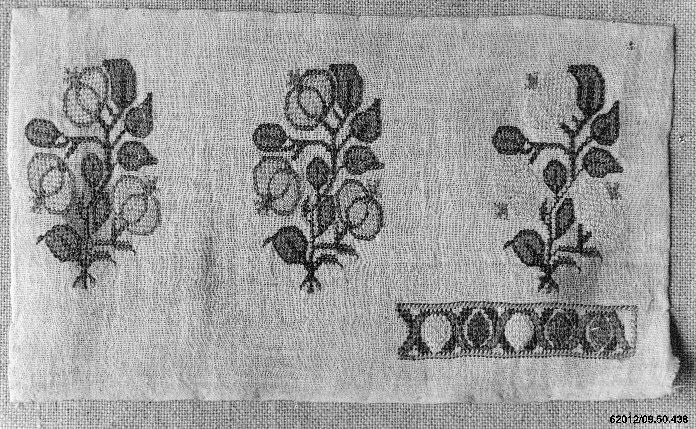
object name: textile fragment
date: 1701-1900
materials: linen, metal thread, silk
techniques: embroidery, weave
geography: syria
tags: flowers